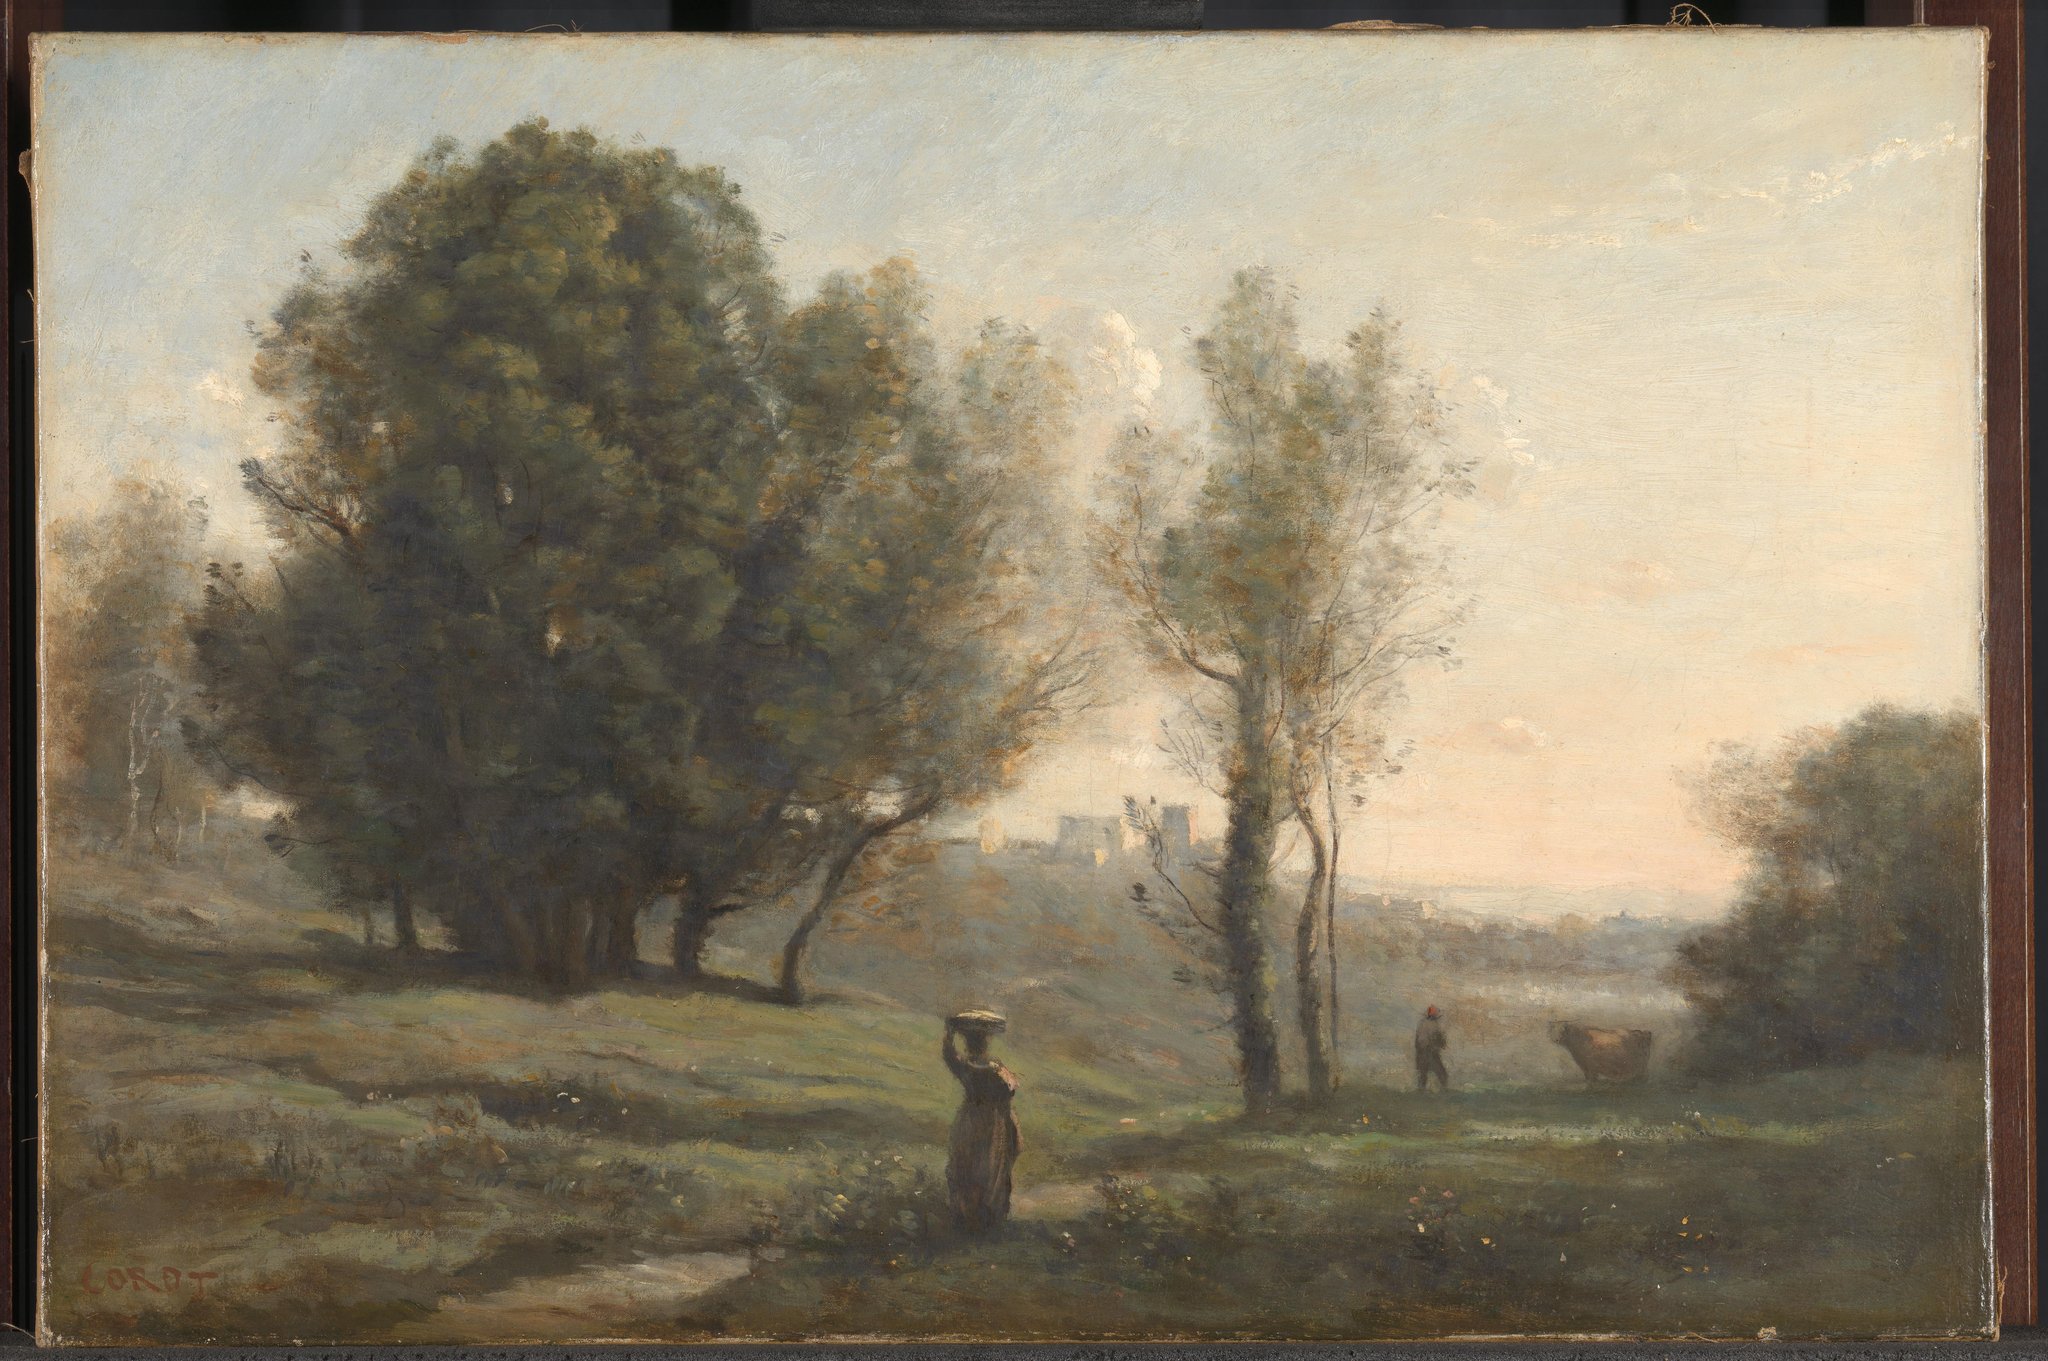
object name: painting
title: Landscape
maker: camille corot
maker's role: draughtsman, painter, print maker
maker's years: 1796-1875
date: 1872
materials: canvas, oil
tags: landscapes in the temperate zone, carrying something on the head or on the shoulders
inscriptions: signature: ‘COROT’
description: Corot belonged to the Barbizon School, which was so widely admired by Hague School artists. Around 1840 several artists settled in the village of Barbizon. They worked en plein air (in the open air) and lived among the peasants. Corot made this painting after a trip to Les Landes, a region south of Bordeaux. It was thus formerly entitled Souvenir de Les Landes.